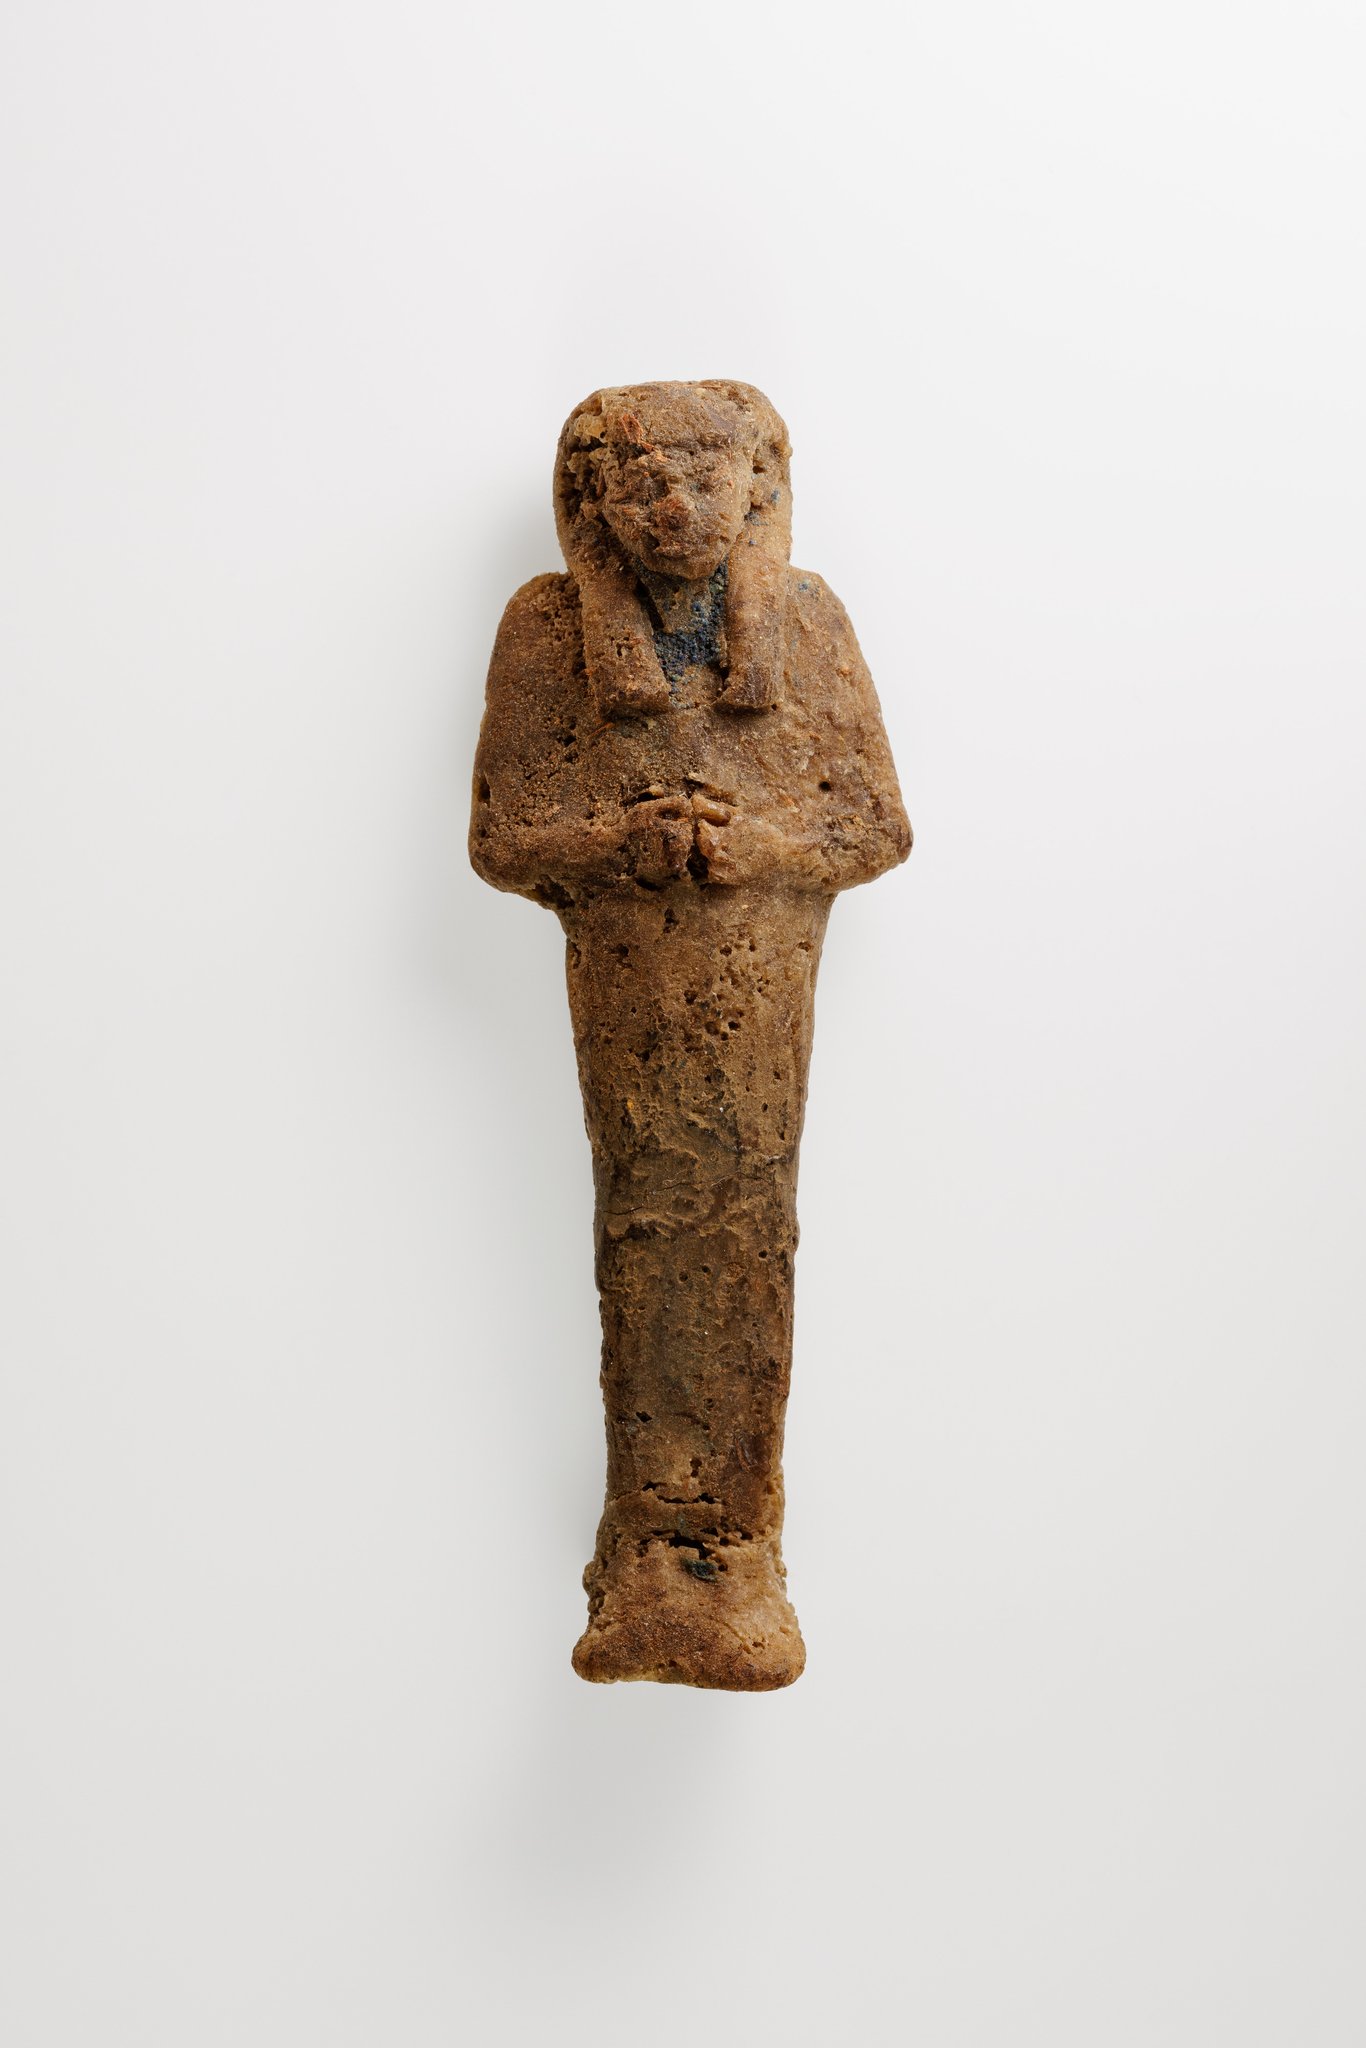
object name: four son of horus, imseti, human headed, nesenaset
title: Viscera figure with human head (Imseti)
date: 1000-945 BCE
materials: mud, wax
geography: egypt